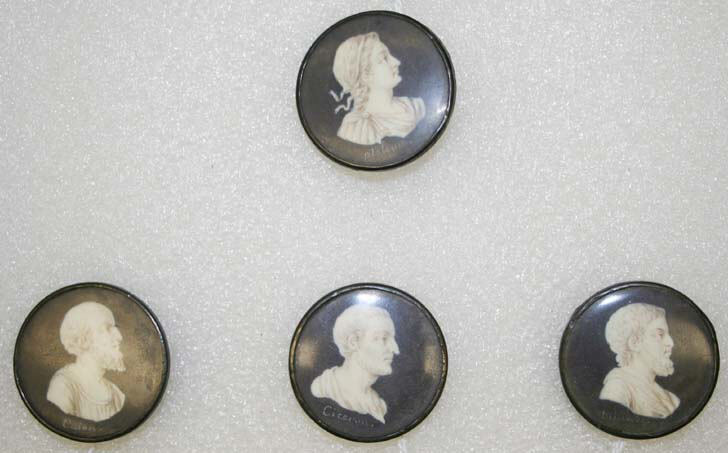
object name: button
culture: french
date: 1775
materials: glass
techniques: grisaille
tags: men,profiles,women